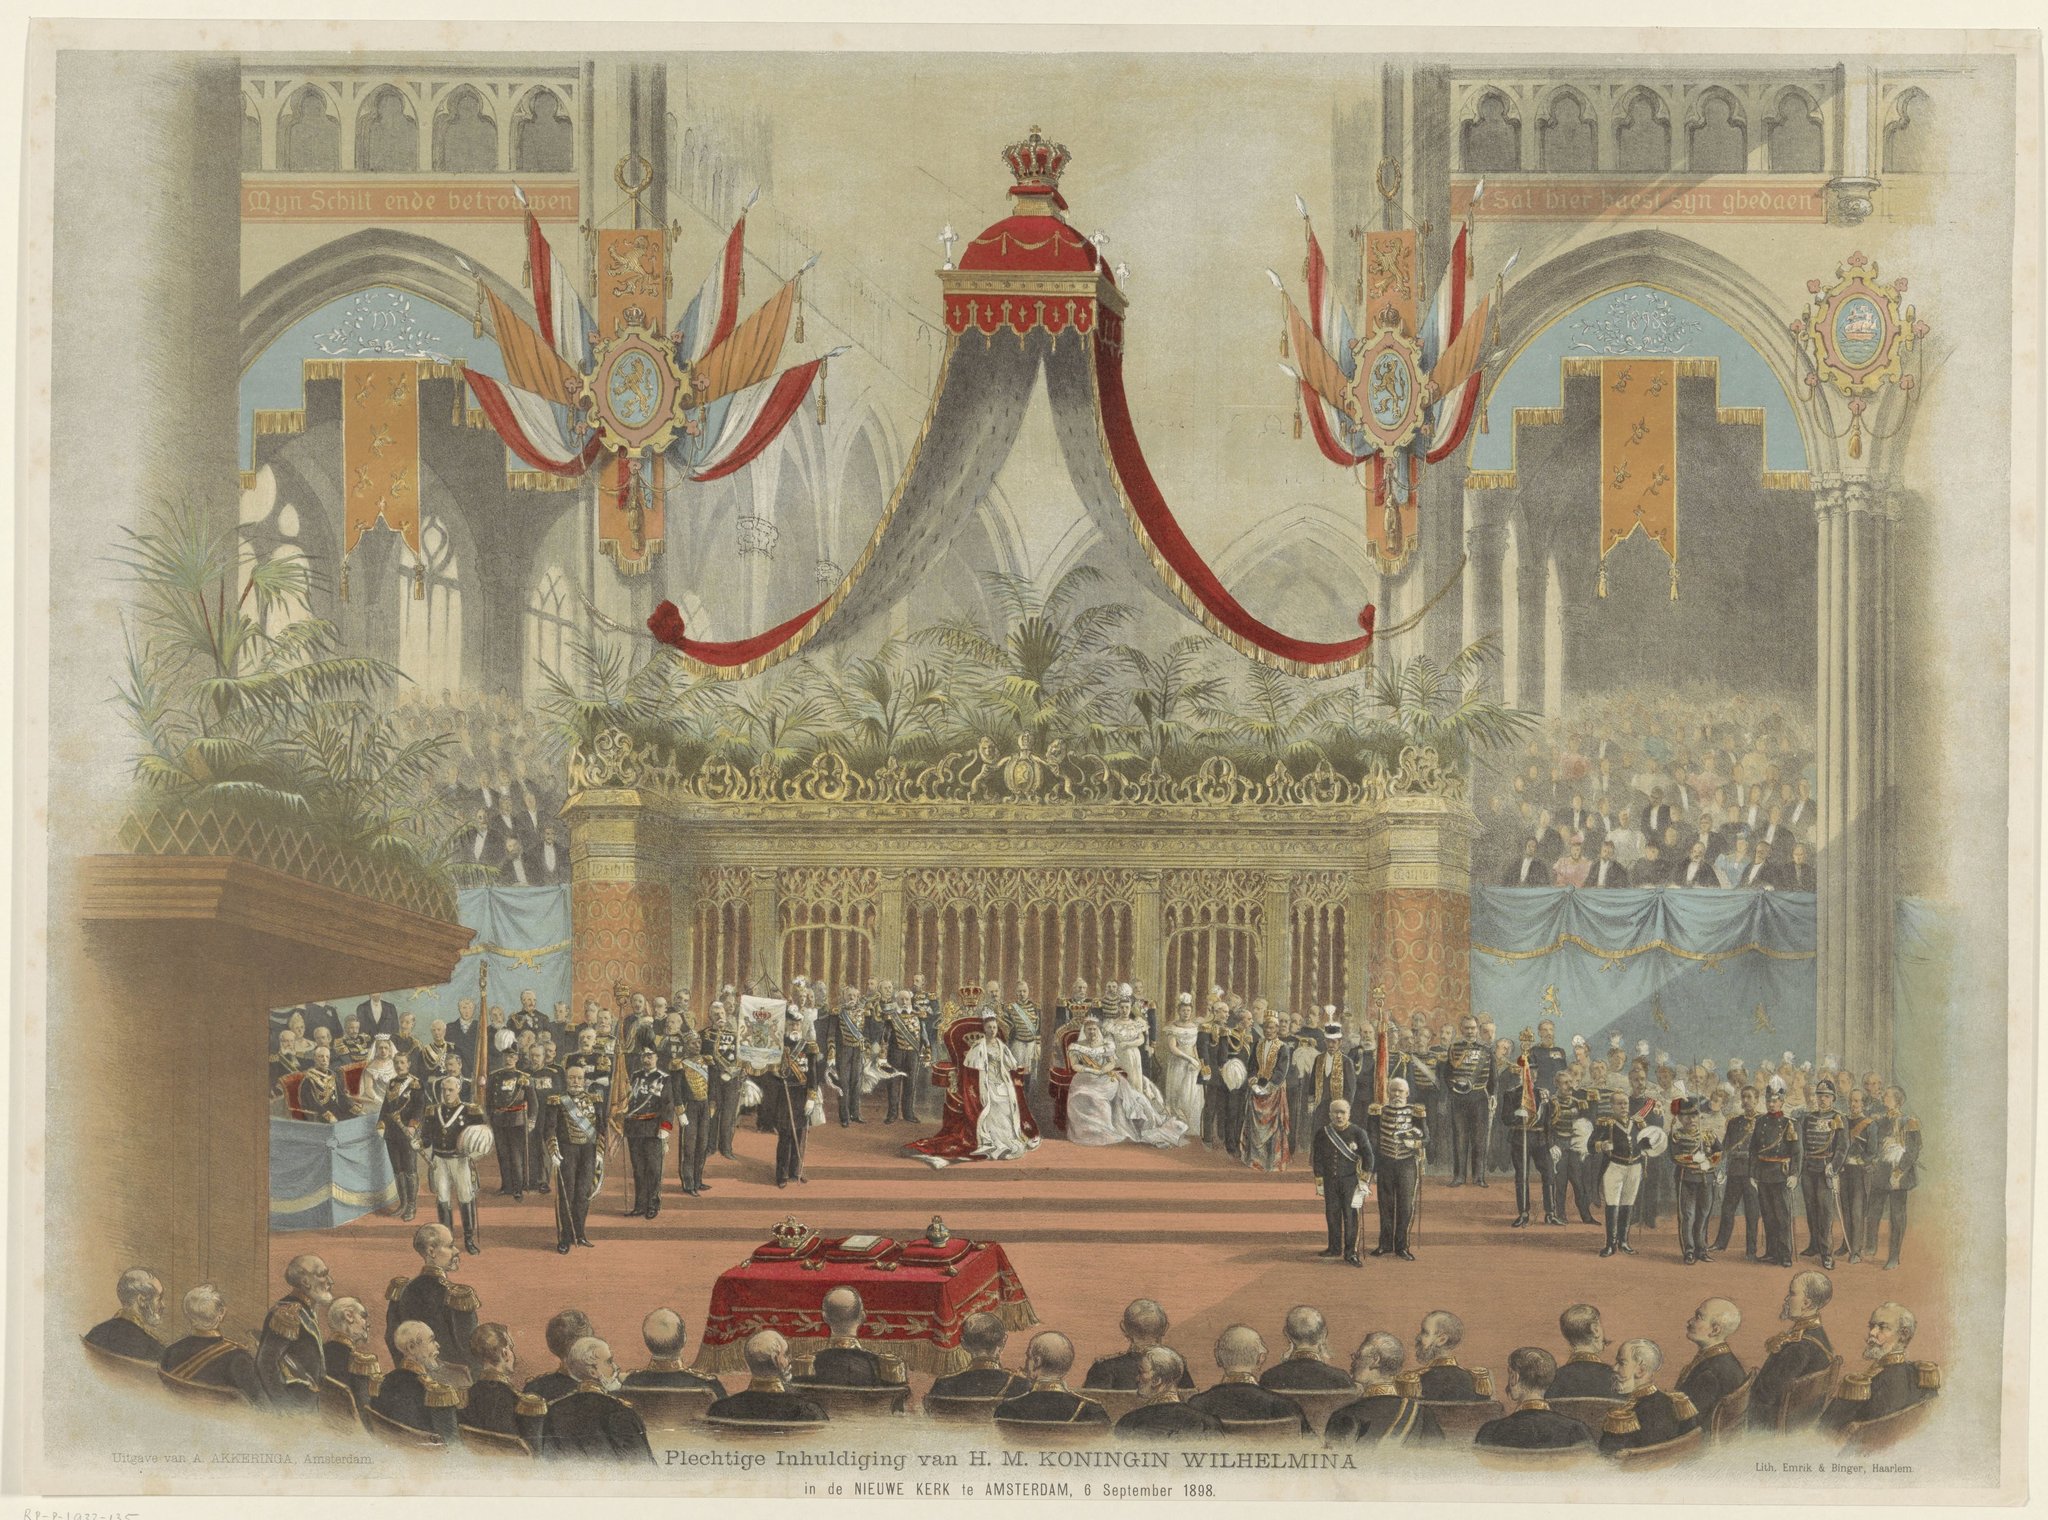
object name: print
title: Plechtige Inhuldiging van H.M. Koningin Wilhelmina in de Nieuwe Kerk te Amsterdam, 6 September 1898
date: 1898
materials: paper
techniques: lithograph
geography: netherlands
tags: print maker, wilhelmina of the netherlands, the hague, emma (queen consort of the netherlands), installation of a ruler - bb - female ruler, amsterdam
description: Inhuldiging van Koningin Wilhelmina in de Nieuwe Kerk te Amsterdam op 6 september 1898. Centraal voor het koorhek Wilhelmina zittend op haar troon naast regentes Emma.